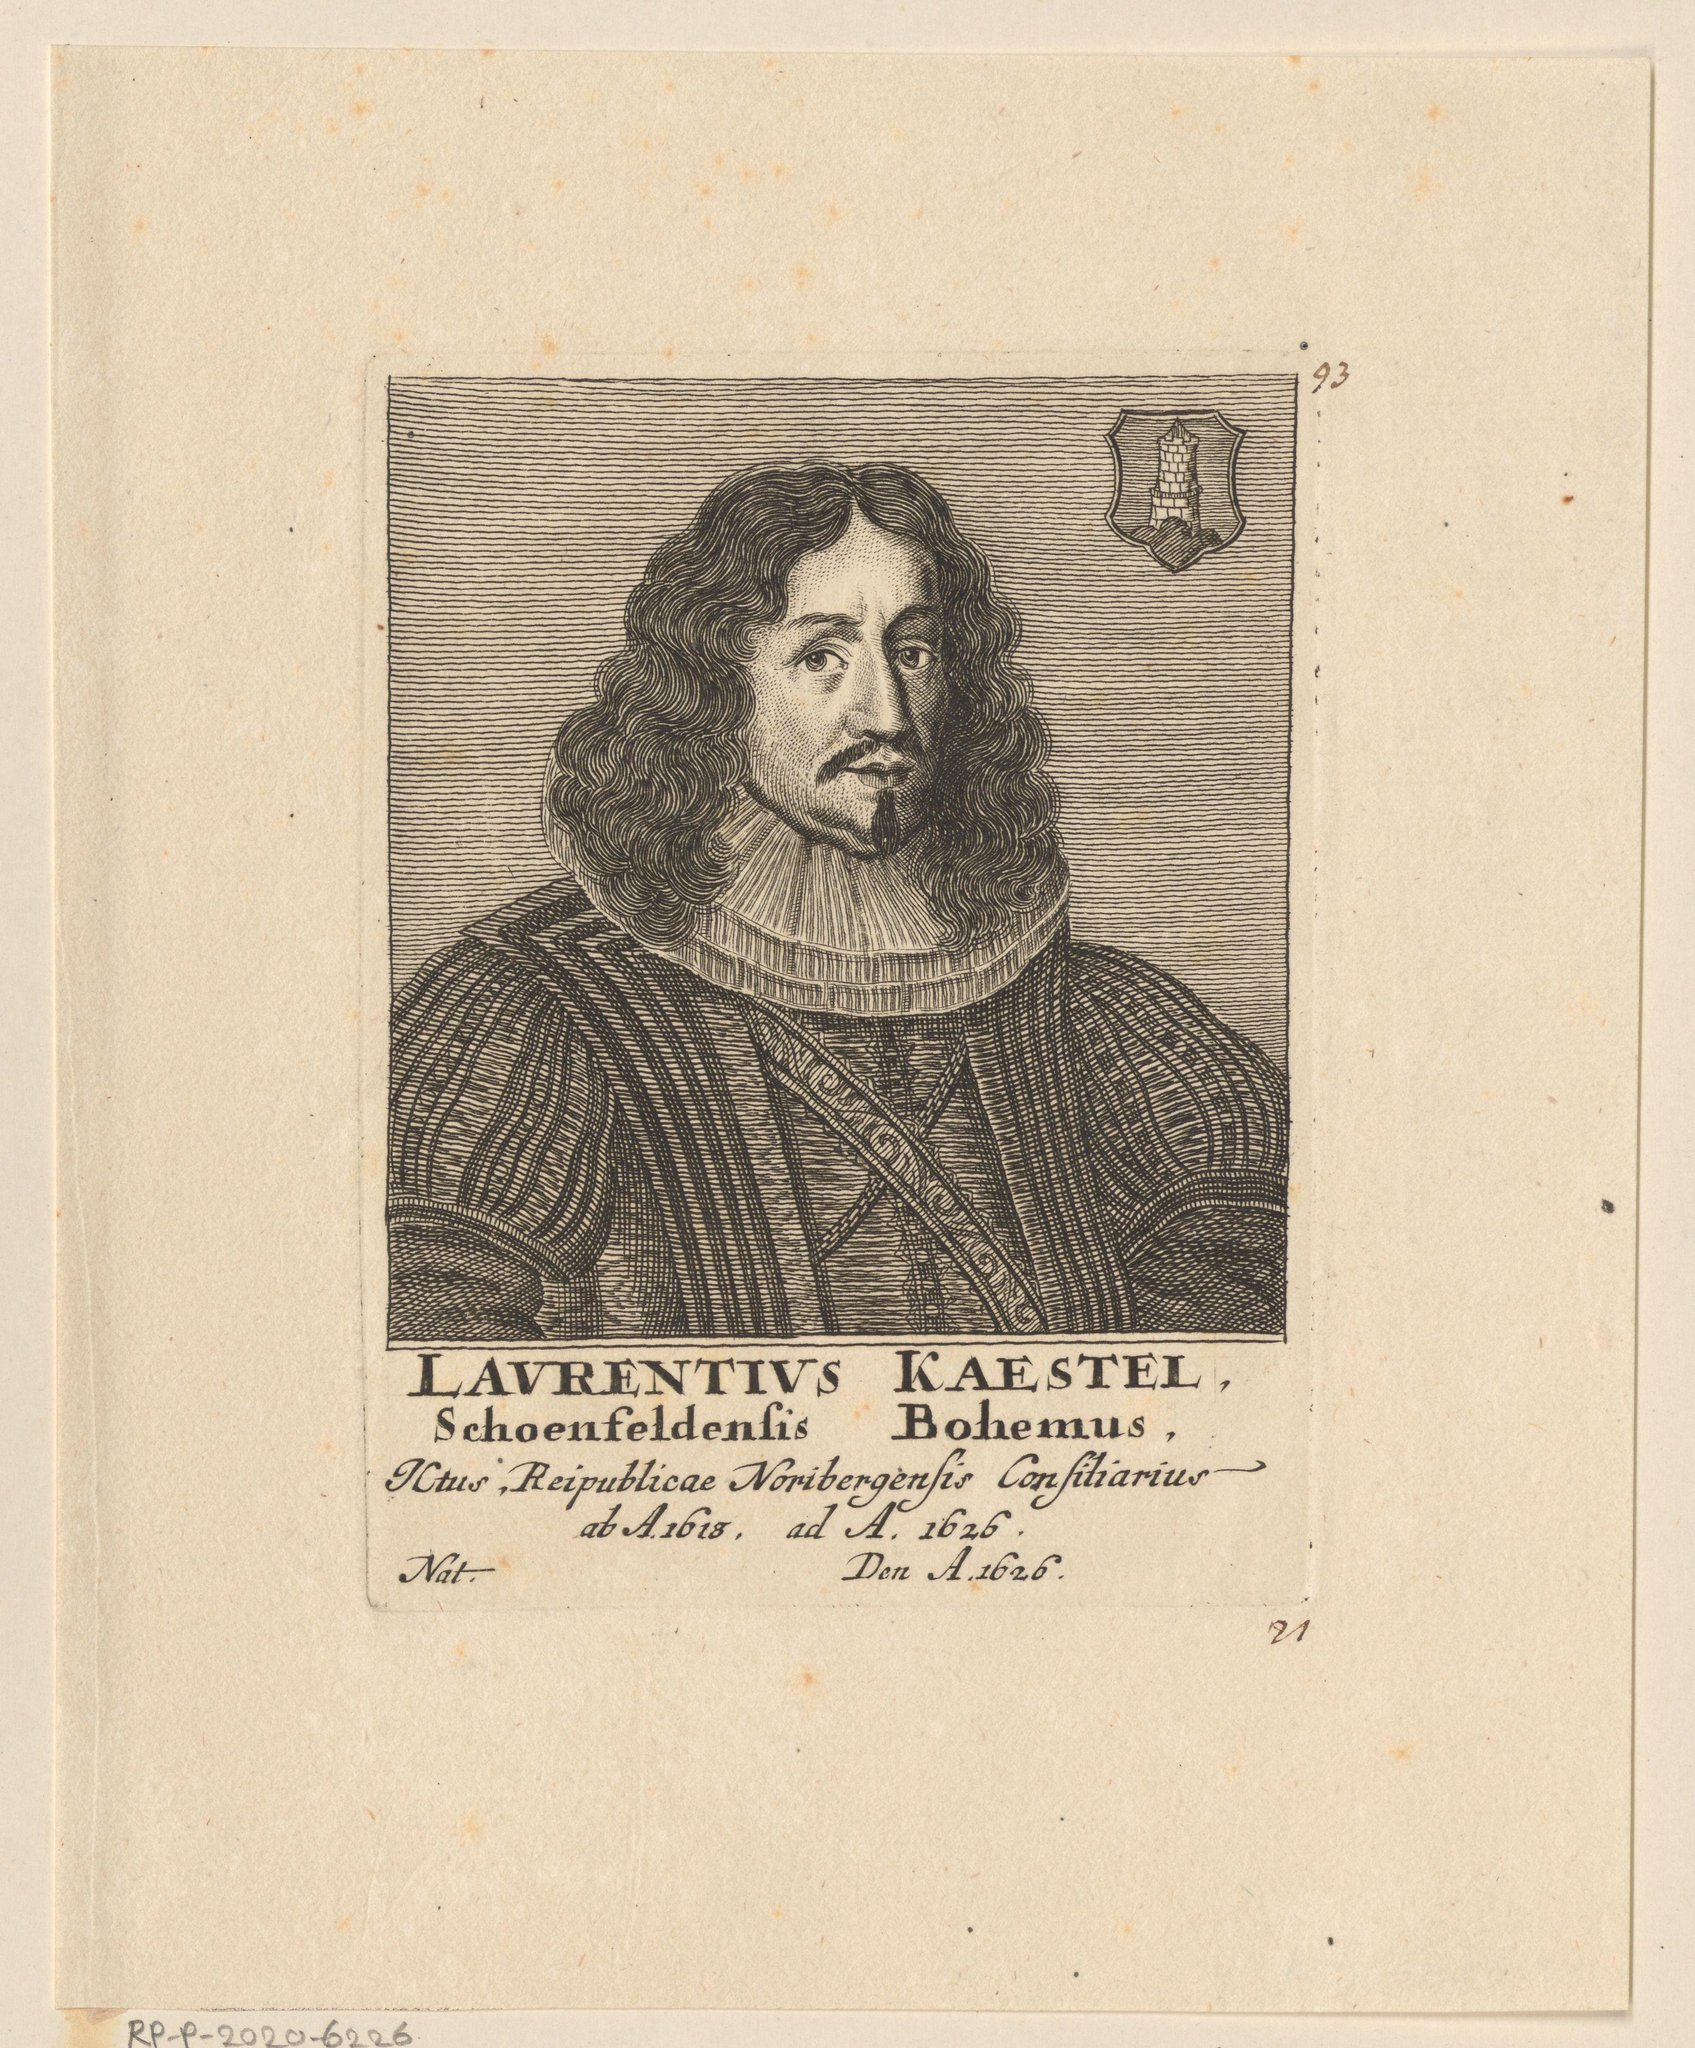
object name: print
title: Portretten van publieke figuren uit Neurenberg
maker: Anonymous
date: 1723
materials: paper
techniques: engraving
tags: historical persons, armorial bearing, heraldry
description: Prent waarschijnlijk uit: Rothscholtz, Friedrich. Icones consiliariorum de illustri republica Noribergensi (...). Neurenberg en Altdorf: erven Johann Daniel Tauber, 1723.